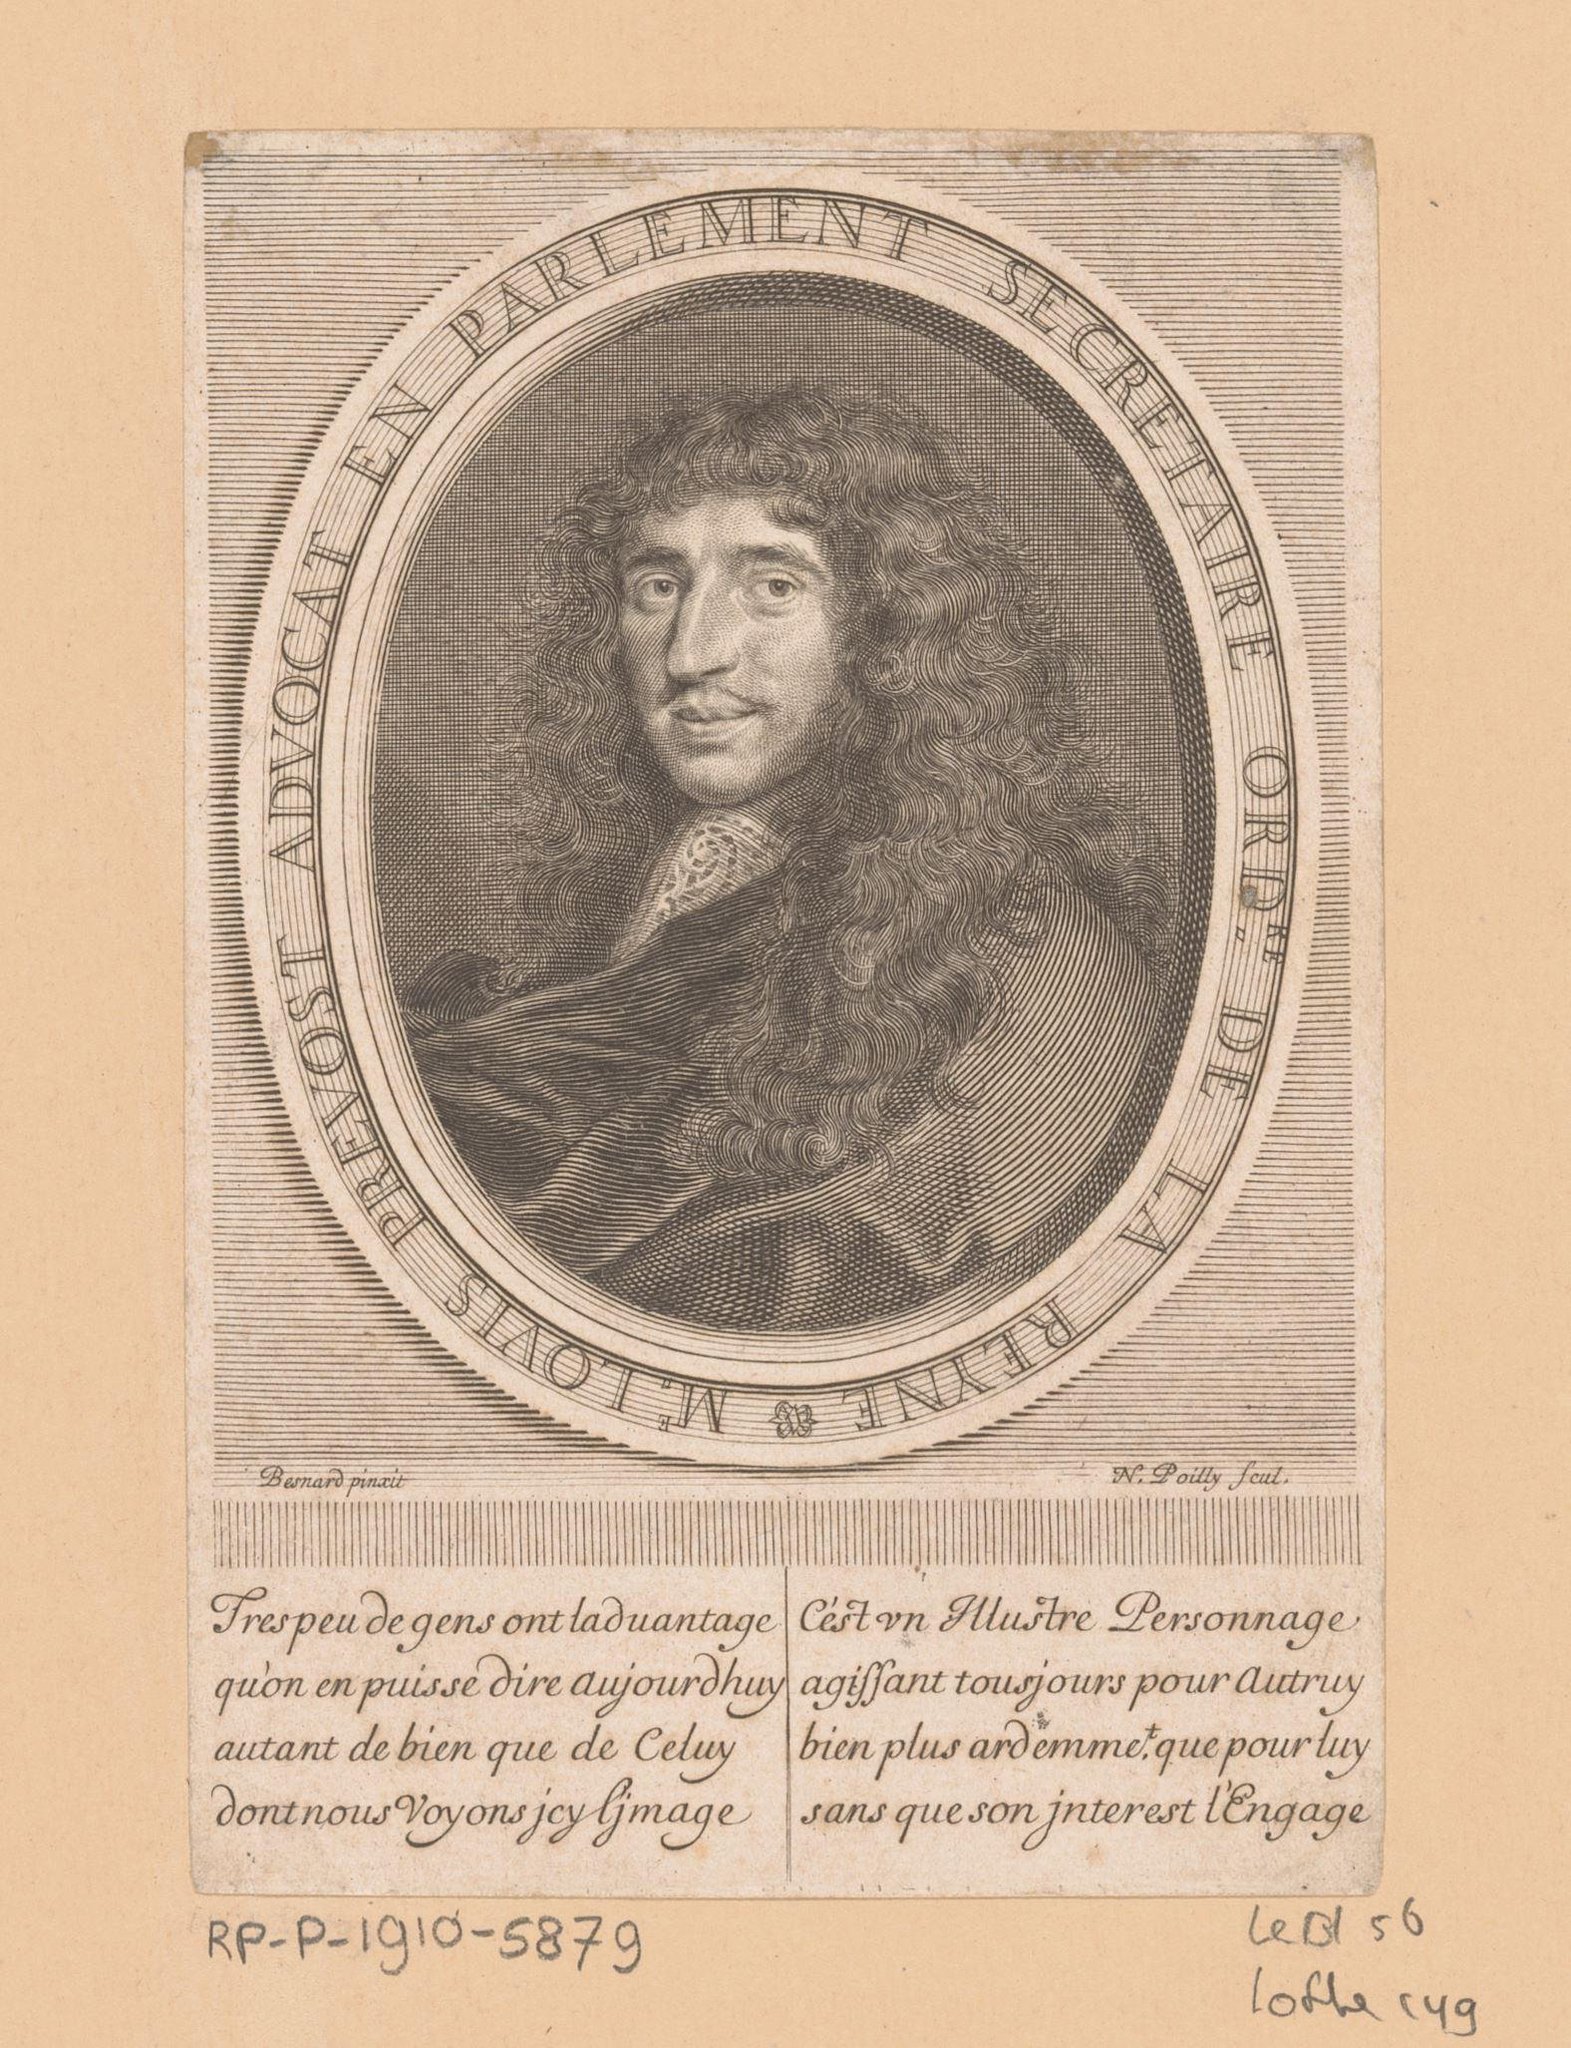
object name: print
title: Portret van Louis Prevost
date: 1636-1696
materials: paper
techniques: engraving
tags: historical persons, lawyer, attorney at law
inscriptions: collector's mark: Lugt 2228